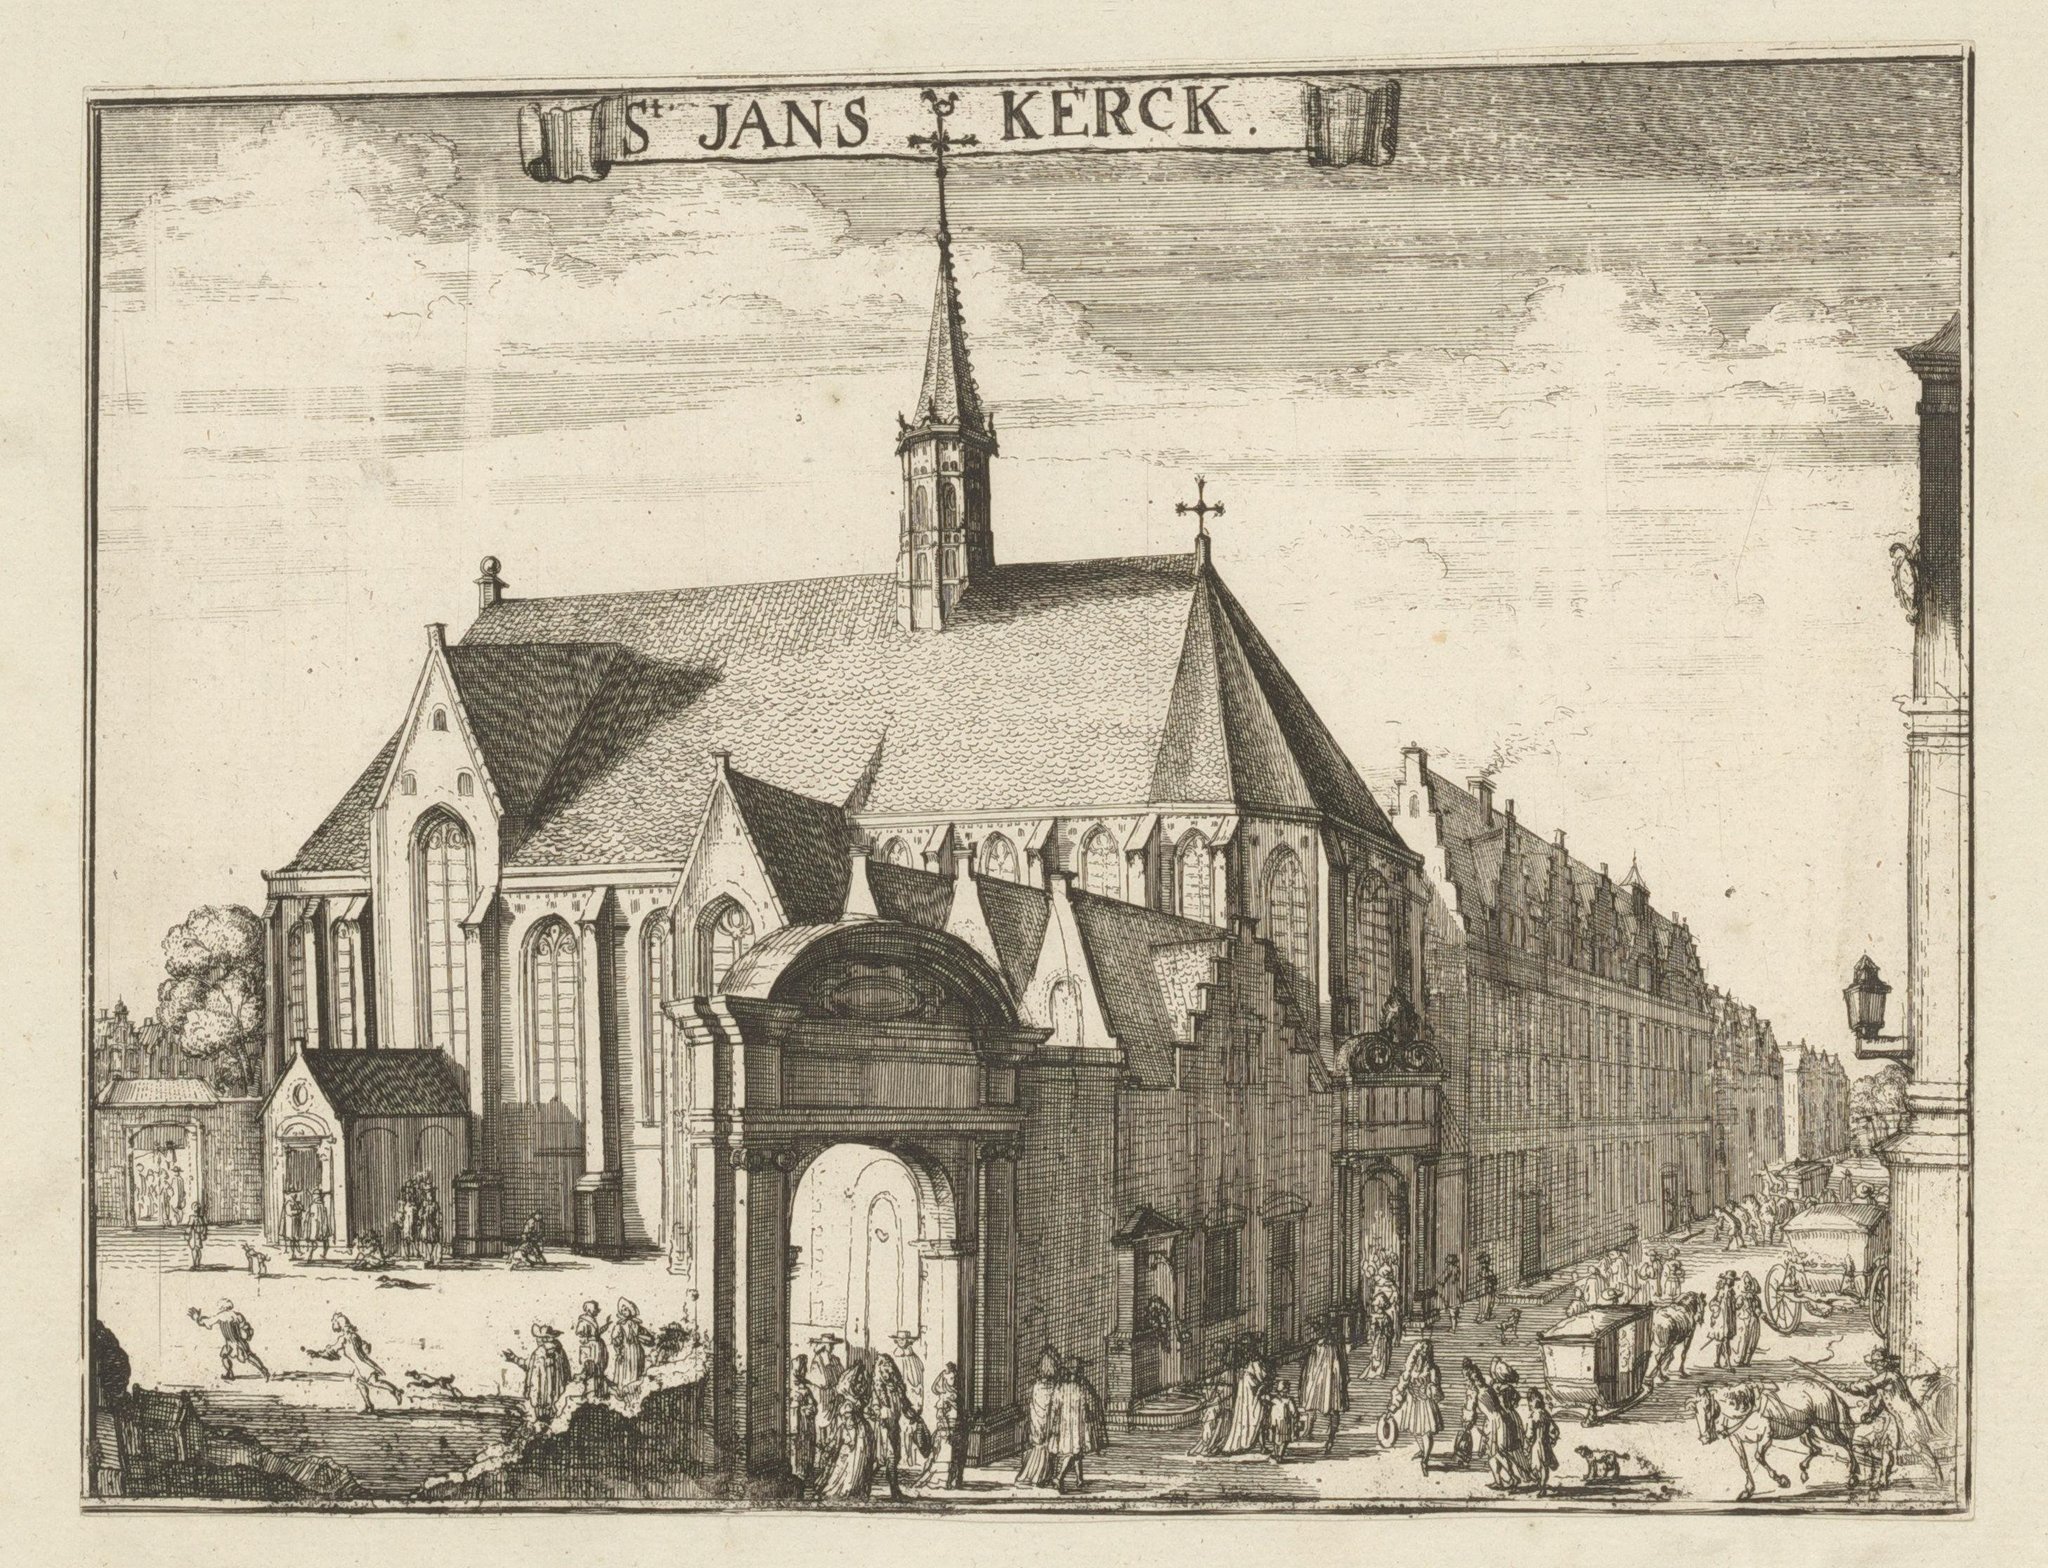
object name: print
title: St. Jans Kerck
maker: romeyn de hooghe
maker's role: draughtsman, goldsmith, painter, print maker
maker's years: 1645-1708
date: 1688-1689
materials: paper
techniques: etching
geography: haarlem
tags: church (exterior)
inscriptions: collector's mark: Lugt 1641, collector's mark: Lugt 692, collector's mark:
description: Gezicht op de Janskerk aan de Jansstraat te Haarlem, met vele mensen en enkele koetsen in de straat ervoor en op het plaatsje ernaast. Deze plaat is gebruikt voor de omvangrijke prent met een grote plattegrond van Haarlem, omgeven door zeven wapenschilden, een profiel van de stad, gezichten op markante Haarlemse gebouwen en voorstellingen van belangrijke momenten uit de Haarlemse geschiedenis. Onderwerpsrubrieken binnen de Atlas Zeden en Gewoonten: Kerk en kerkwezen & Armwezen en liefdadige instellingen; Kerkgebouwen elders. F-L.